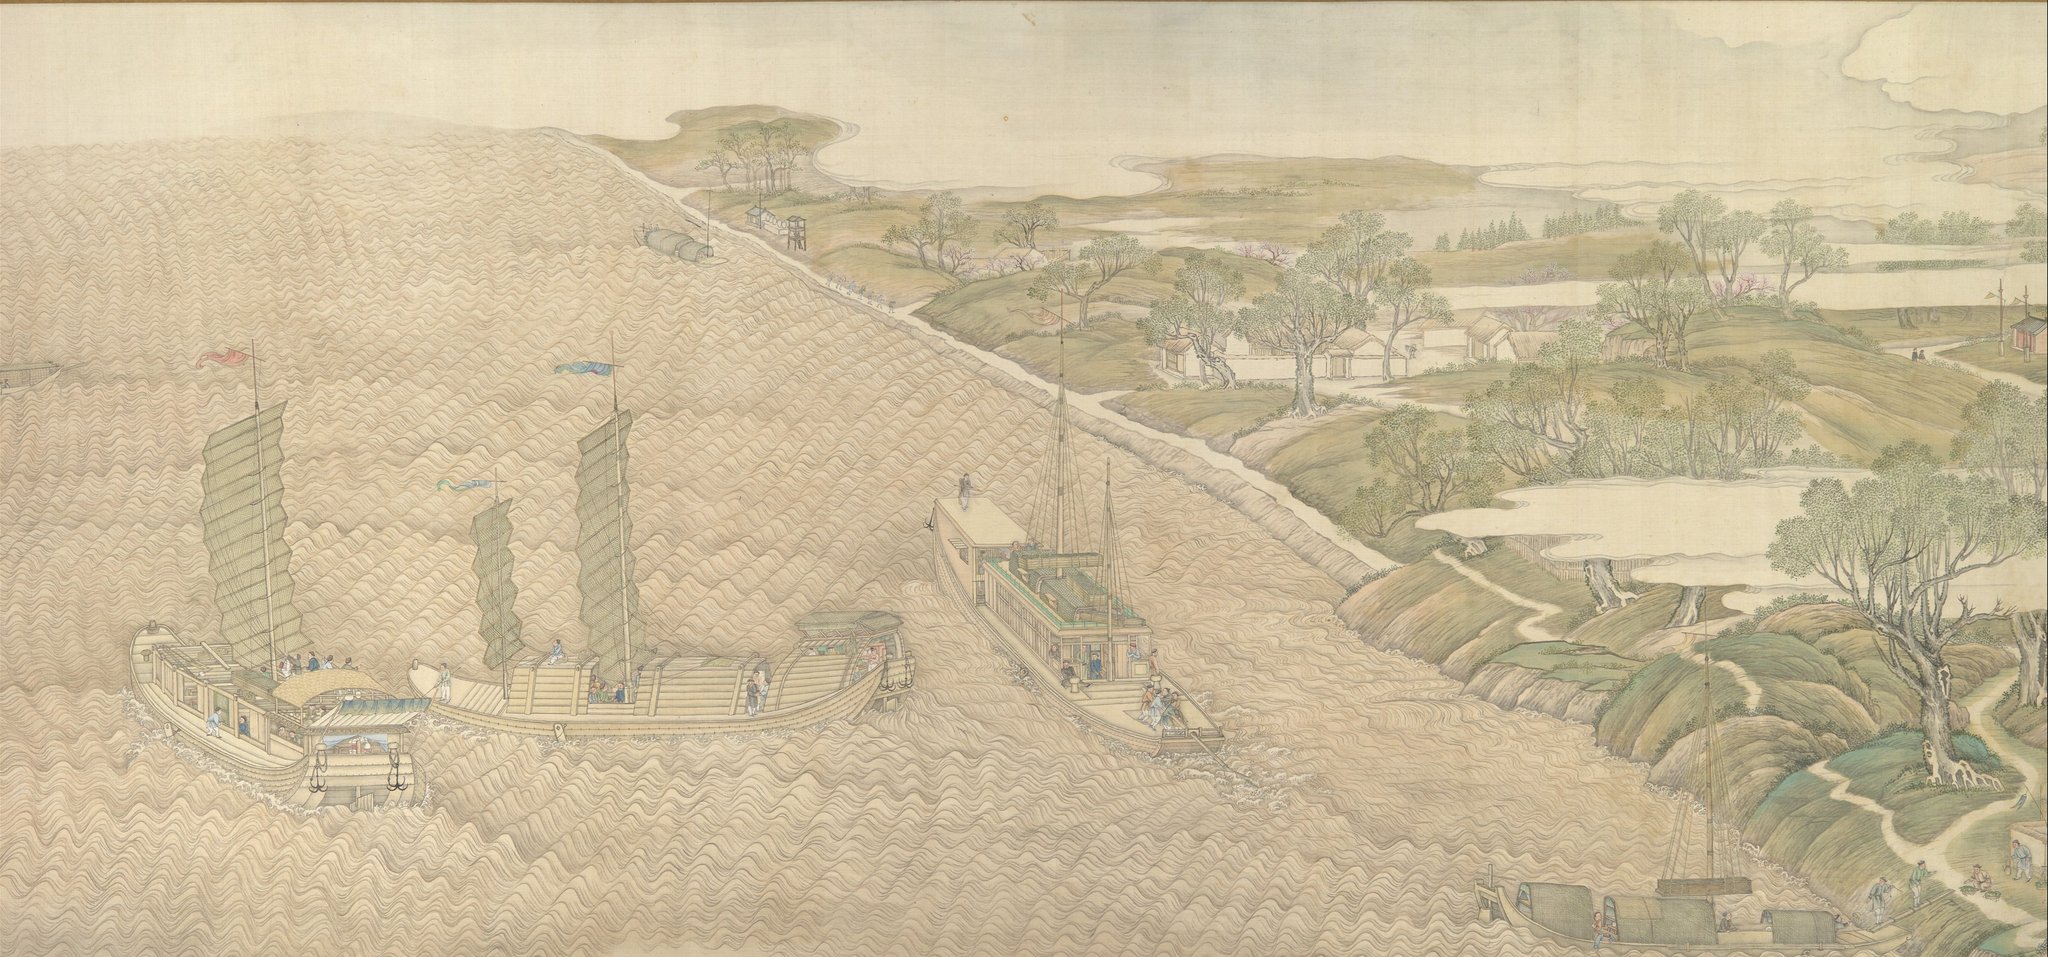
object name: handscroll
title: The Qianlong Emperor's Southern Inspection Tour, Scroll Four: The Confluence of the Huai and Yellow Rivers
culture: chinese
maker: xu yang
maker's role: artist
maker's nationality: chinese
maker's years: 1750-1776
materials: ink, lacquer, silk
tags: rivers,landscapes,boats